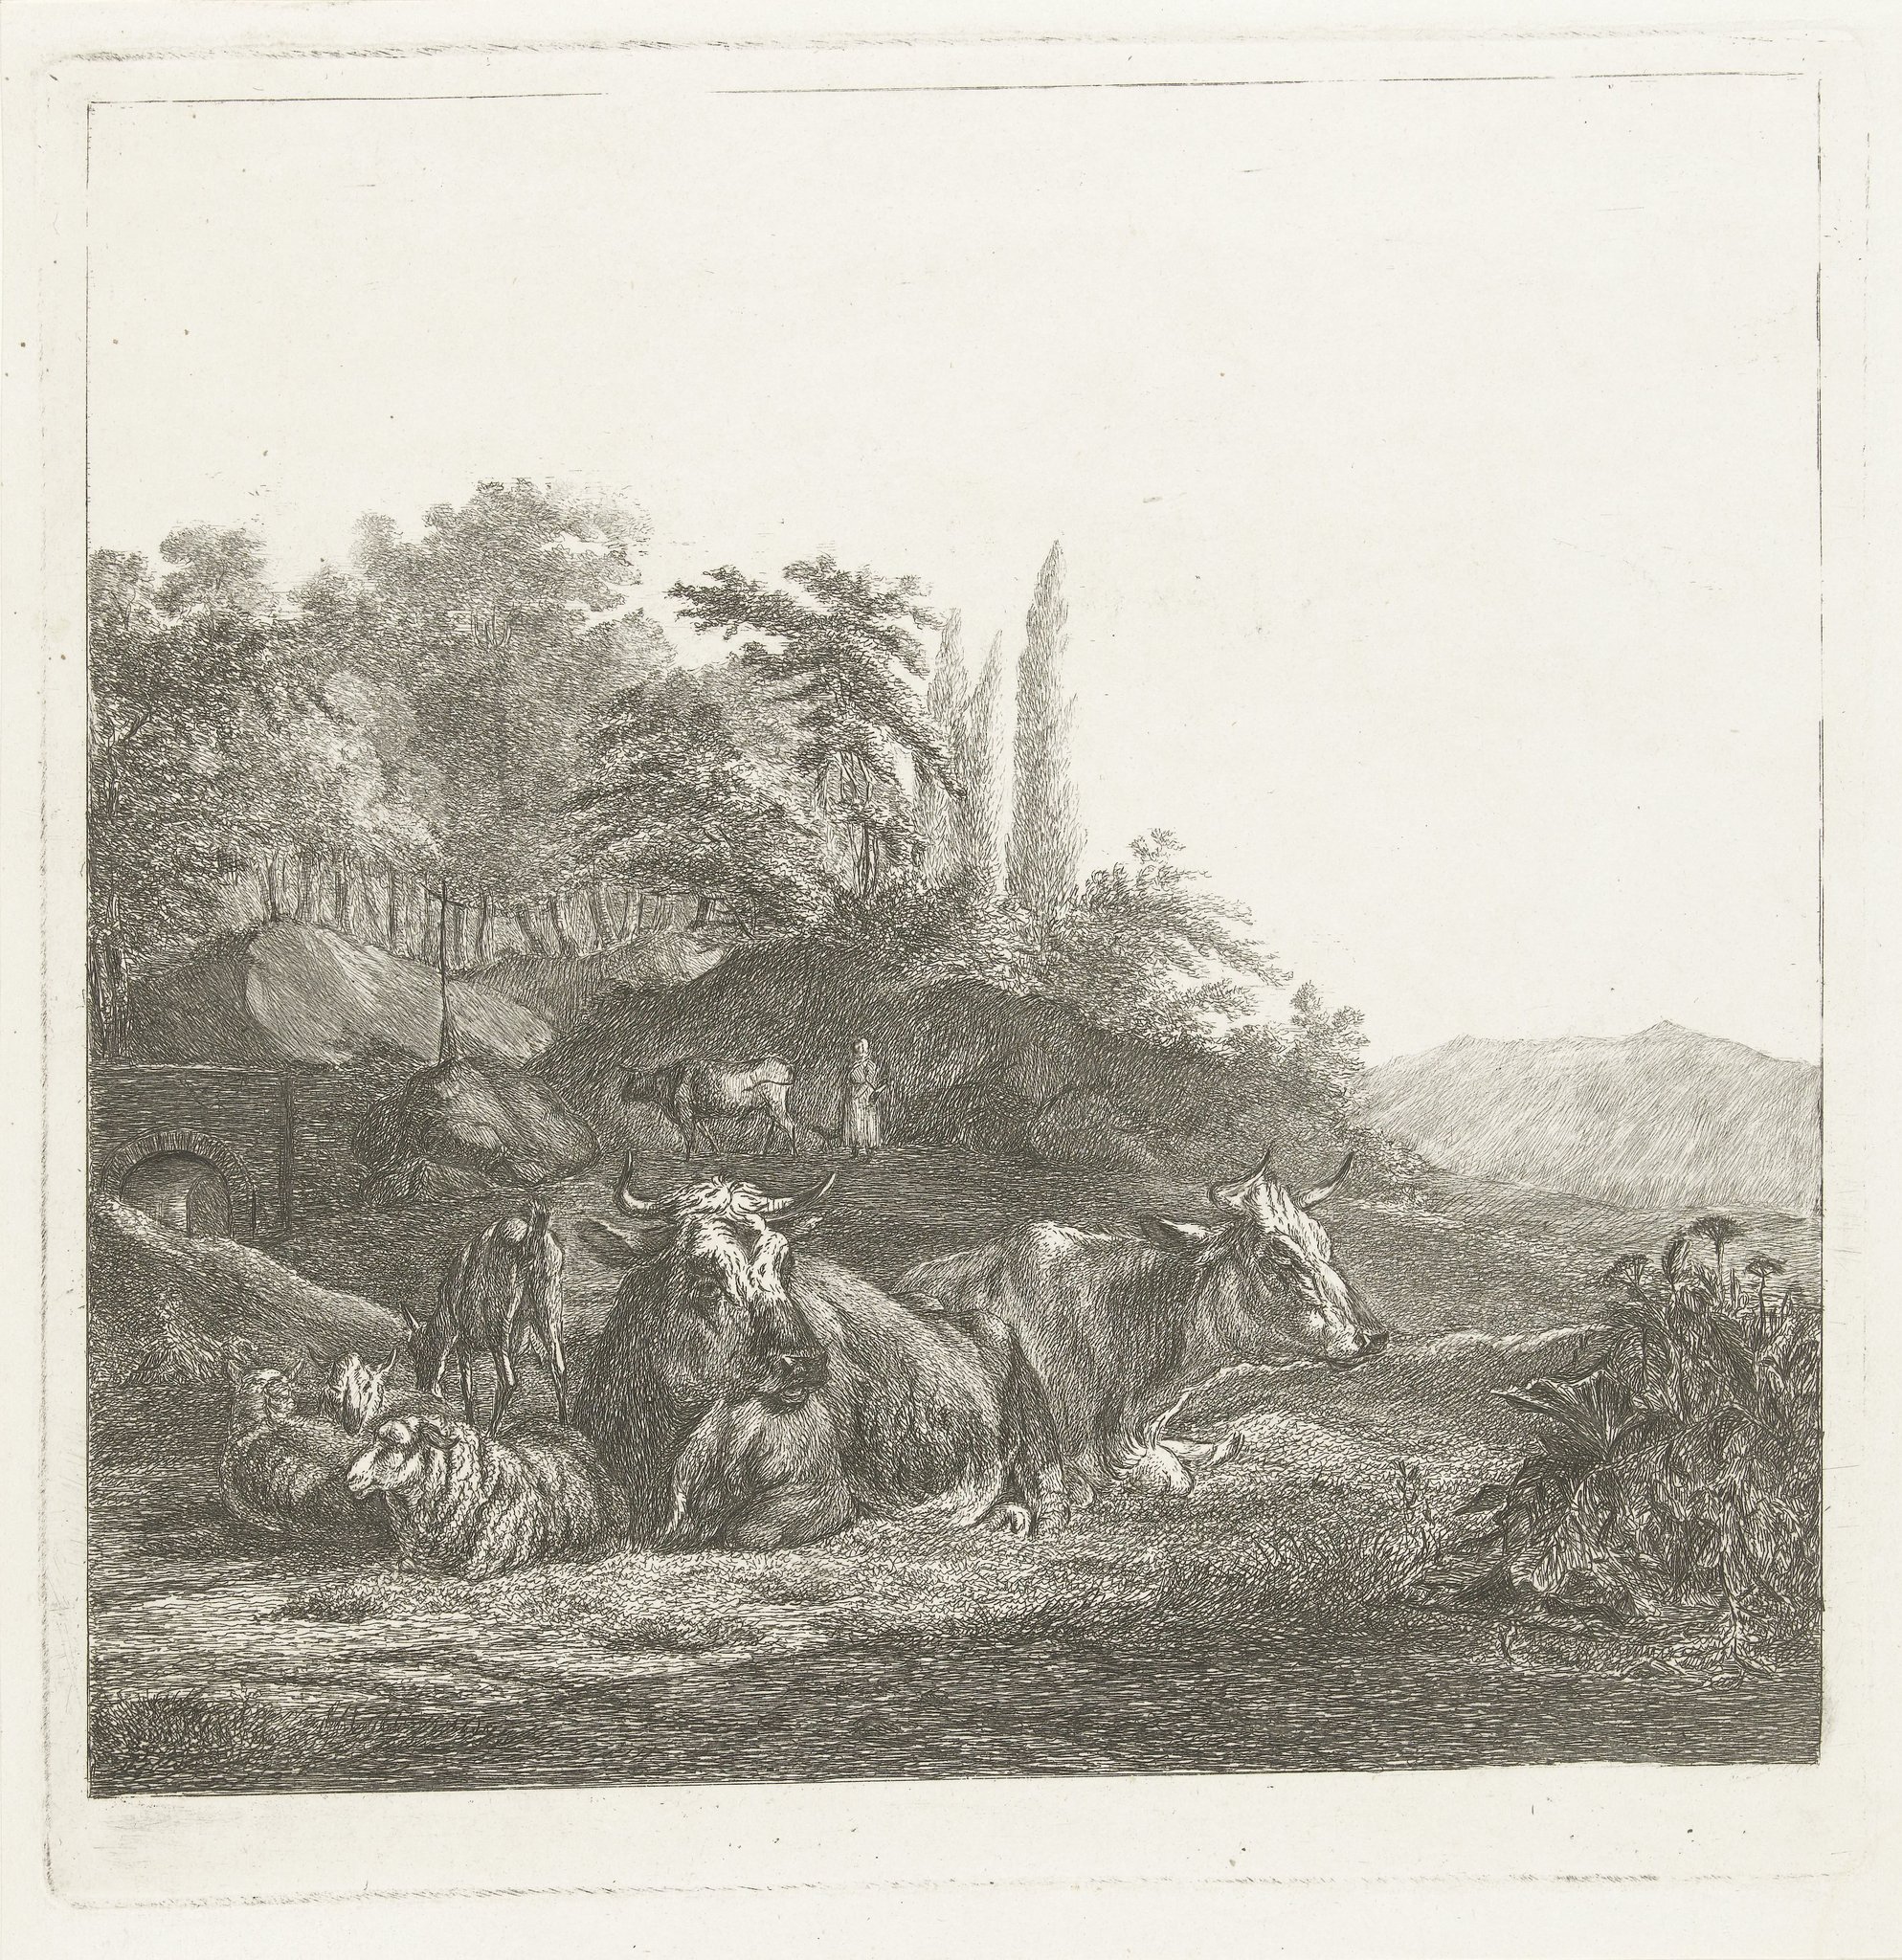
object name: print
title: Twee koeien en drie liggende schapen bij een brug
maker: jacobus cornelis gaal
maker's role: print maker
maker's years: 1796-1866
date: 1852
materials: paper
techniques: etching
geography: netherlands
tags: cattle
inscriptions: collector's mark: Lugt 2228